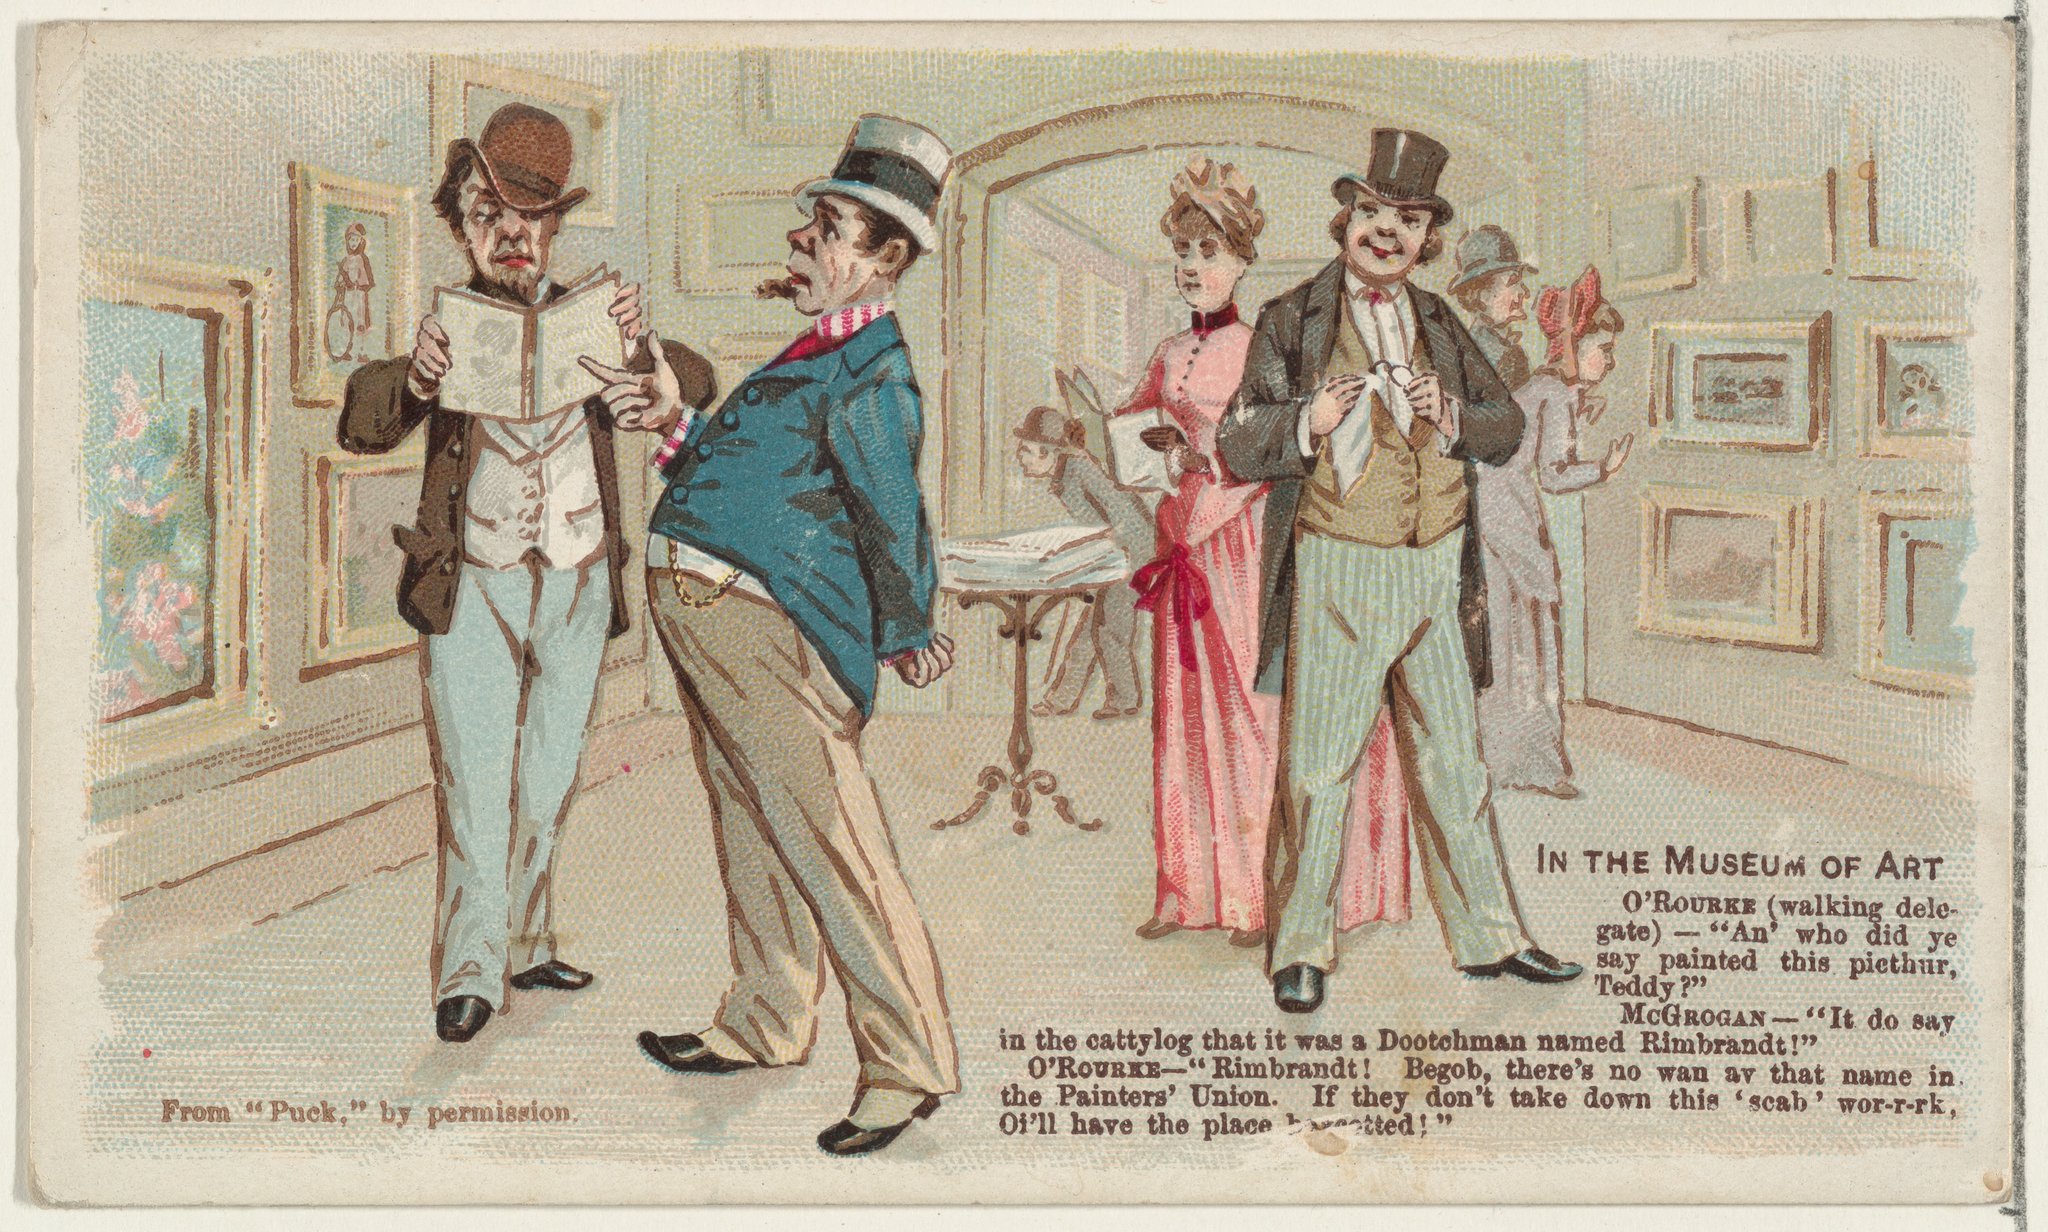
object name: print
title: In the Museum of Art, from the Snapshots from "Puck" series (N128) issued by Duke Sons & Co. to promote Honest Long Cut Tobacco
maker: w. duke, sons & co.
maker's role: publisher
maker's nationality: american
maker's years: 1870-1920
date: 1888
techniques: color lithograph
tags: men,women,reading